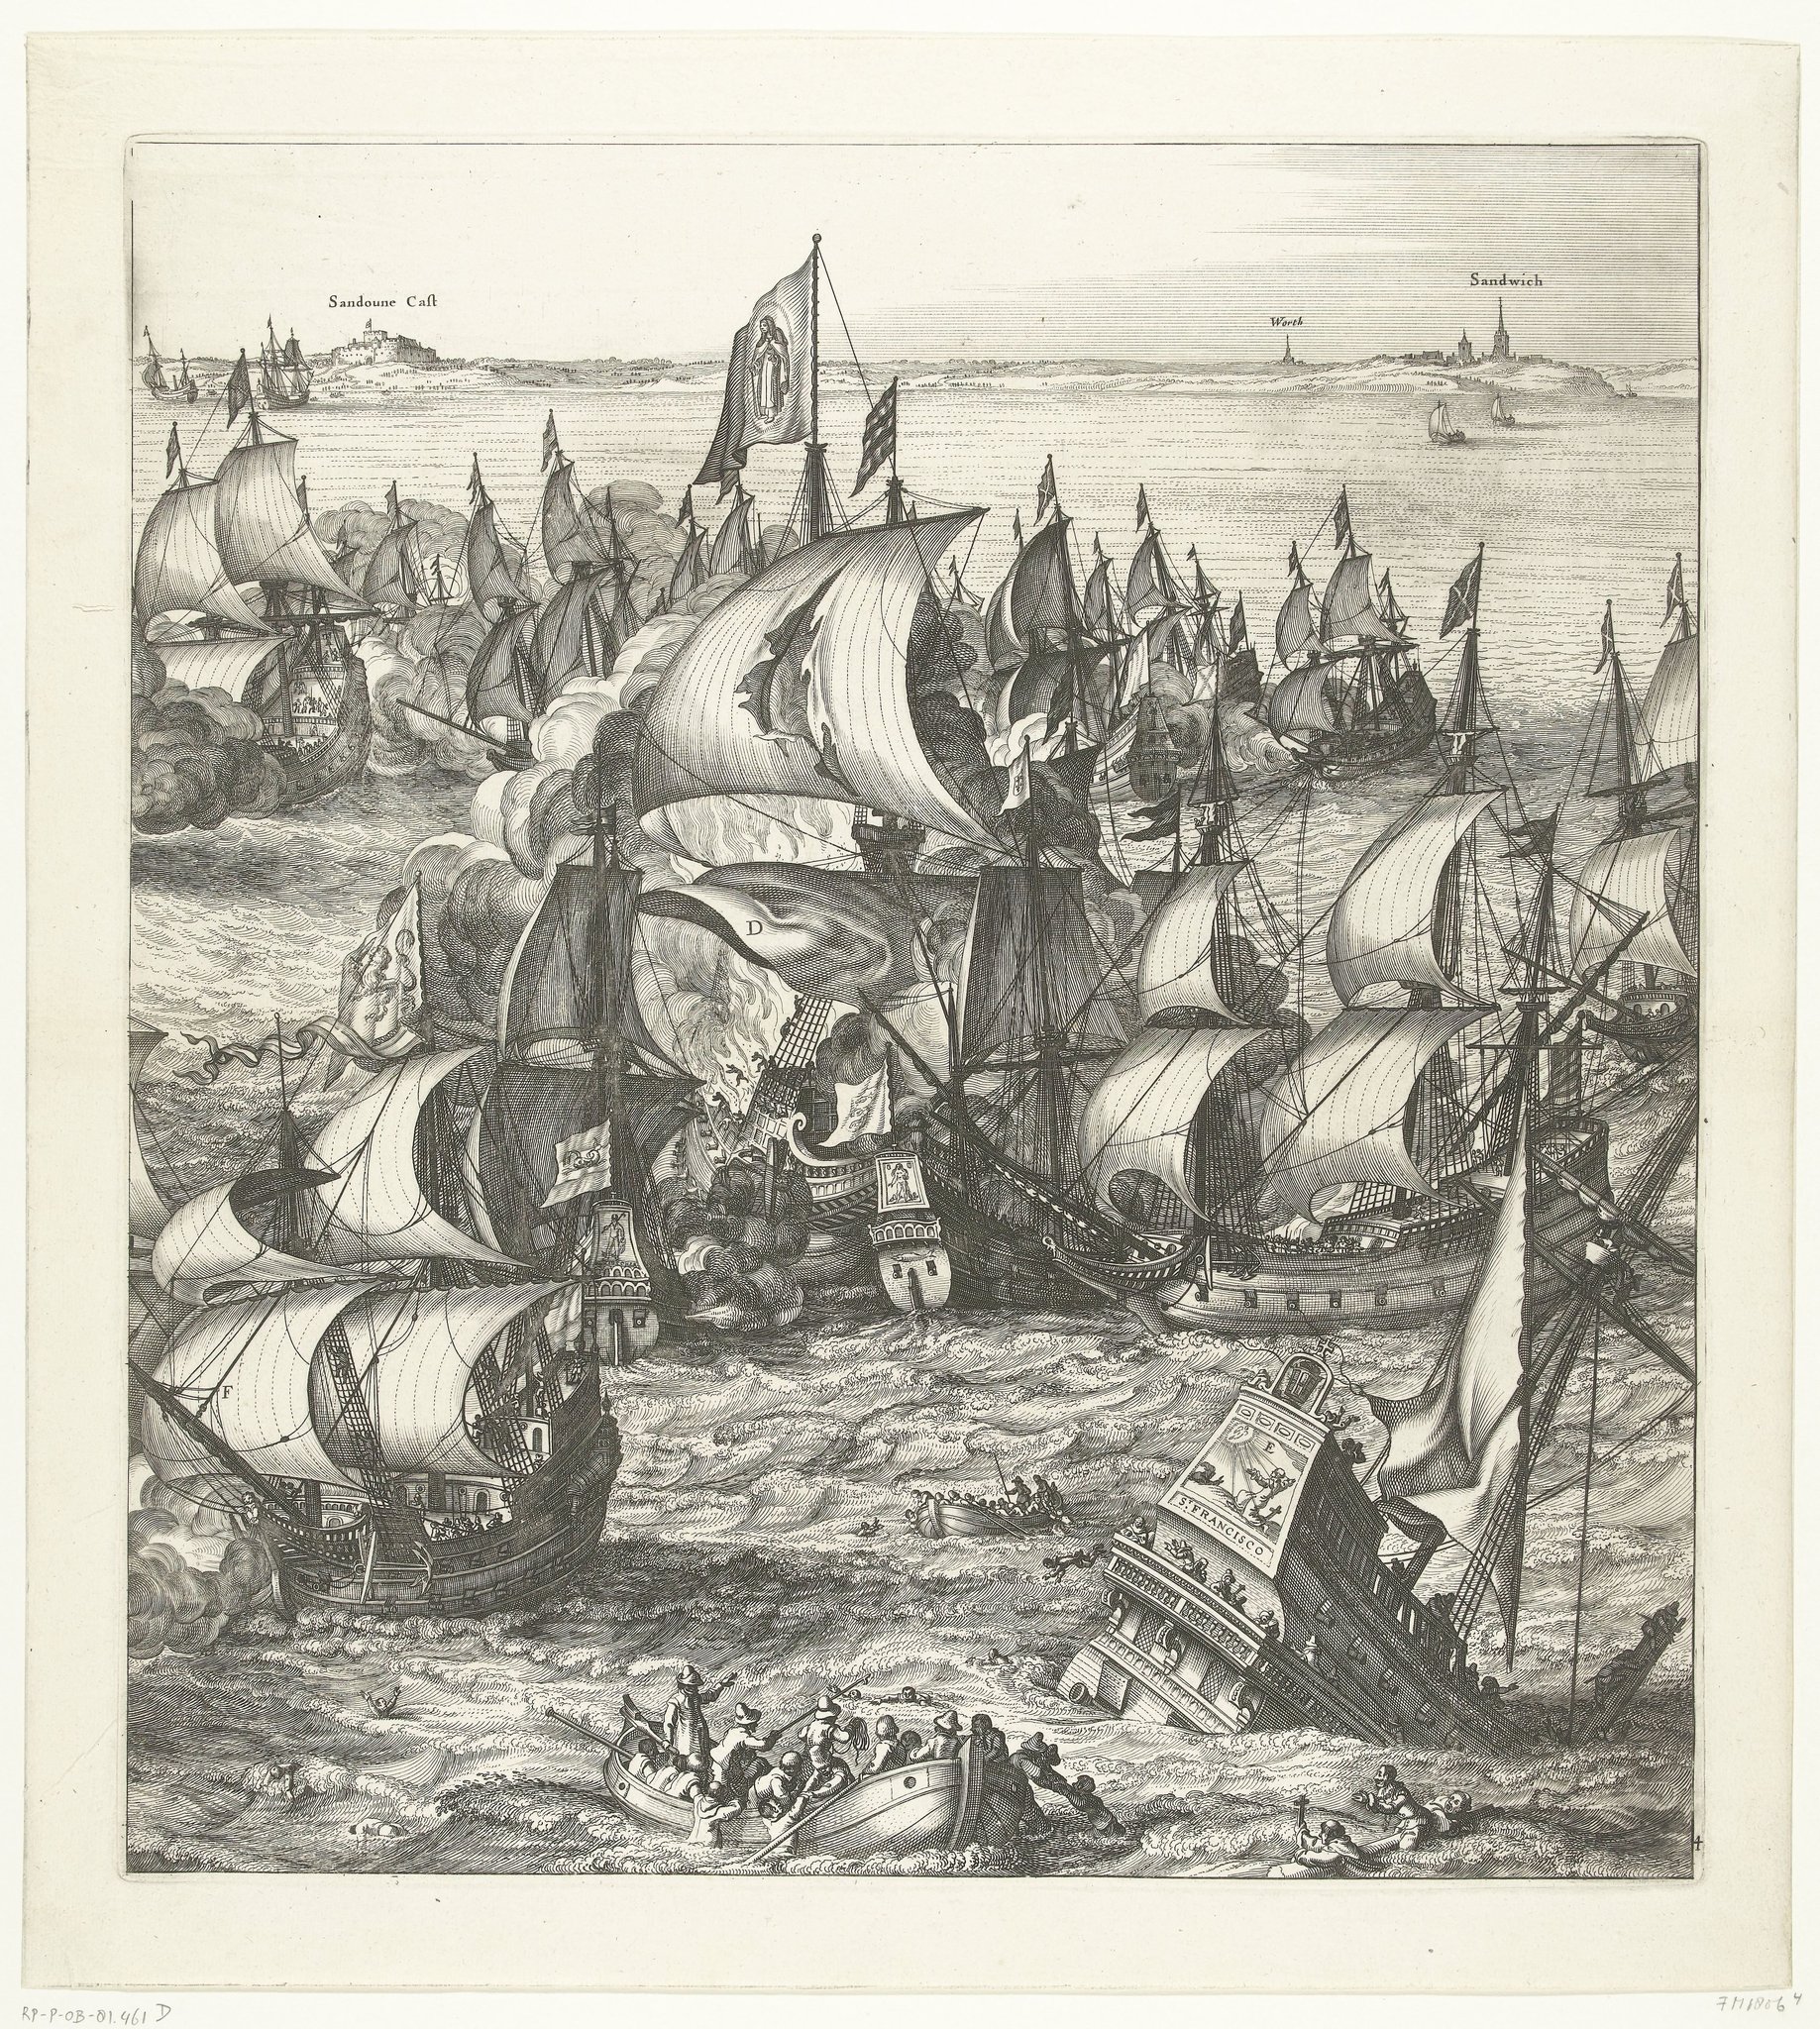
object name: print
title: Pugna navalis qua Hispanos vicere in Duins Angliae Belgae Foederati Ao. MDCXXXIX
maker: claes jansz. visscher (ii)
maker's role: draughtsman, print maker, publisher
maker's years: 1586-1652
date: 1640-1643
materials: paper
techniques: engraving, etching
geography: amsterdam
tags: brielle, maarten harpertszoon tromp, battle (+ naval force), battle of the downs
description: Grote voorstelling van de zeeslag bij Duins tussen de Spaanse vloot onder bevel van Antonio de Oquendo en de Staatse vloot onder Maarten Harpertsz. Tromp, 21 oktober 1639. Blad 4: gevechten op zee, centraal de verwoesting van de Santa Teresa, op de voorgrond worden bij de zinkende St. Francisco drenkelingen uit het water gehaald. Op de achtergrond de Engelse kust bij Sandwich. Ongemonteerde ensemble bestaande uit 7 genummerde platen, de zwarte stroken met de titel en tekstblad met de beschrijving.